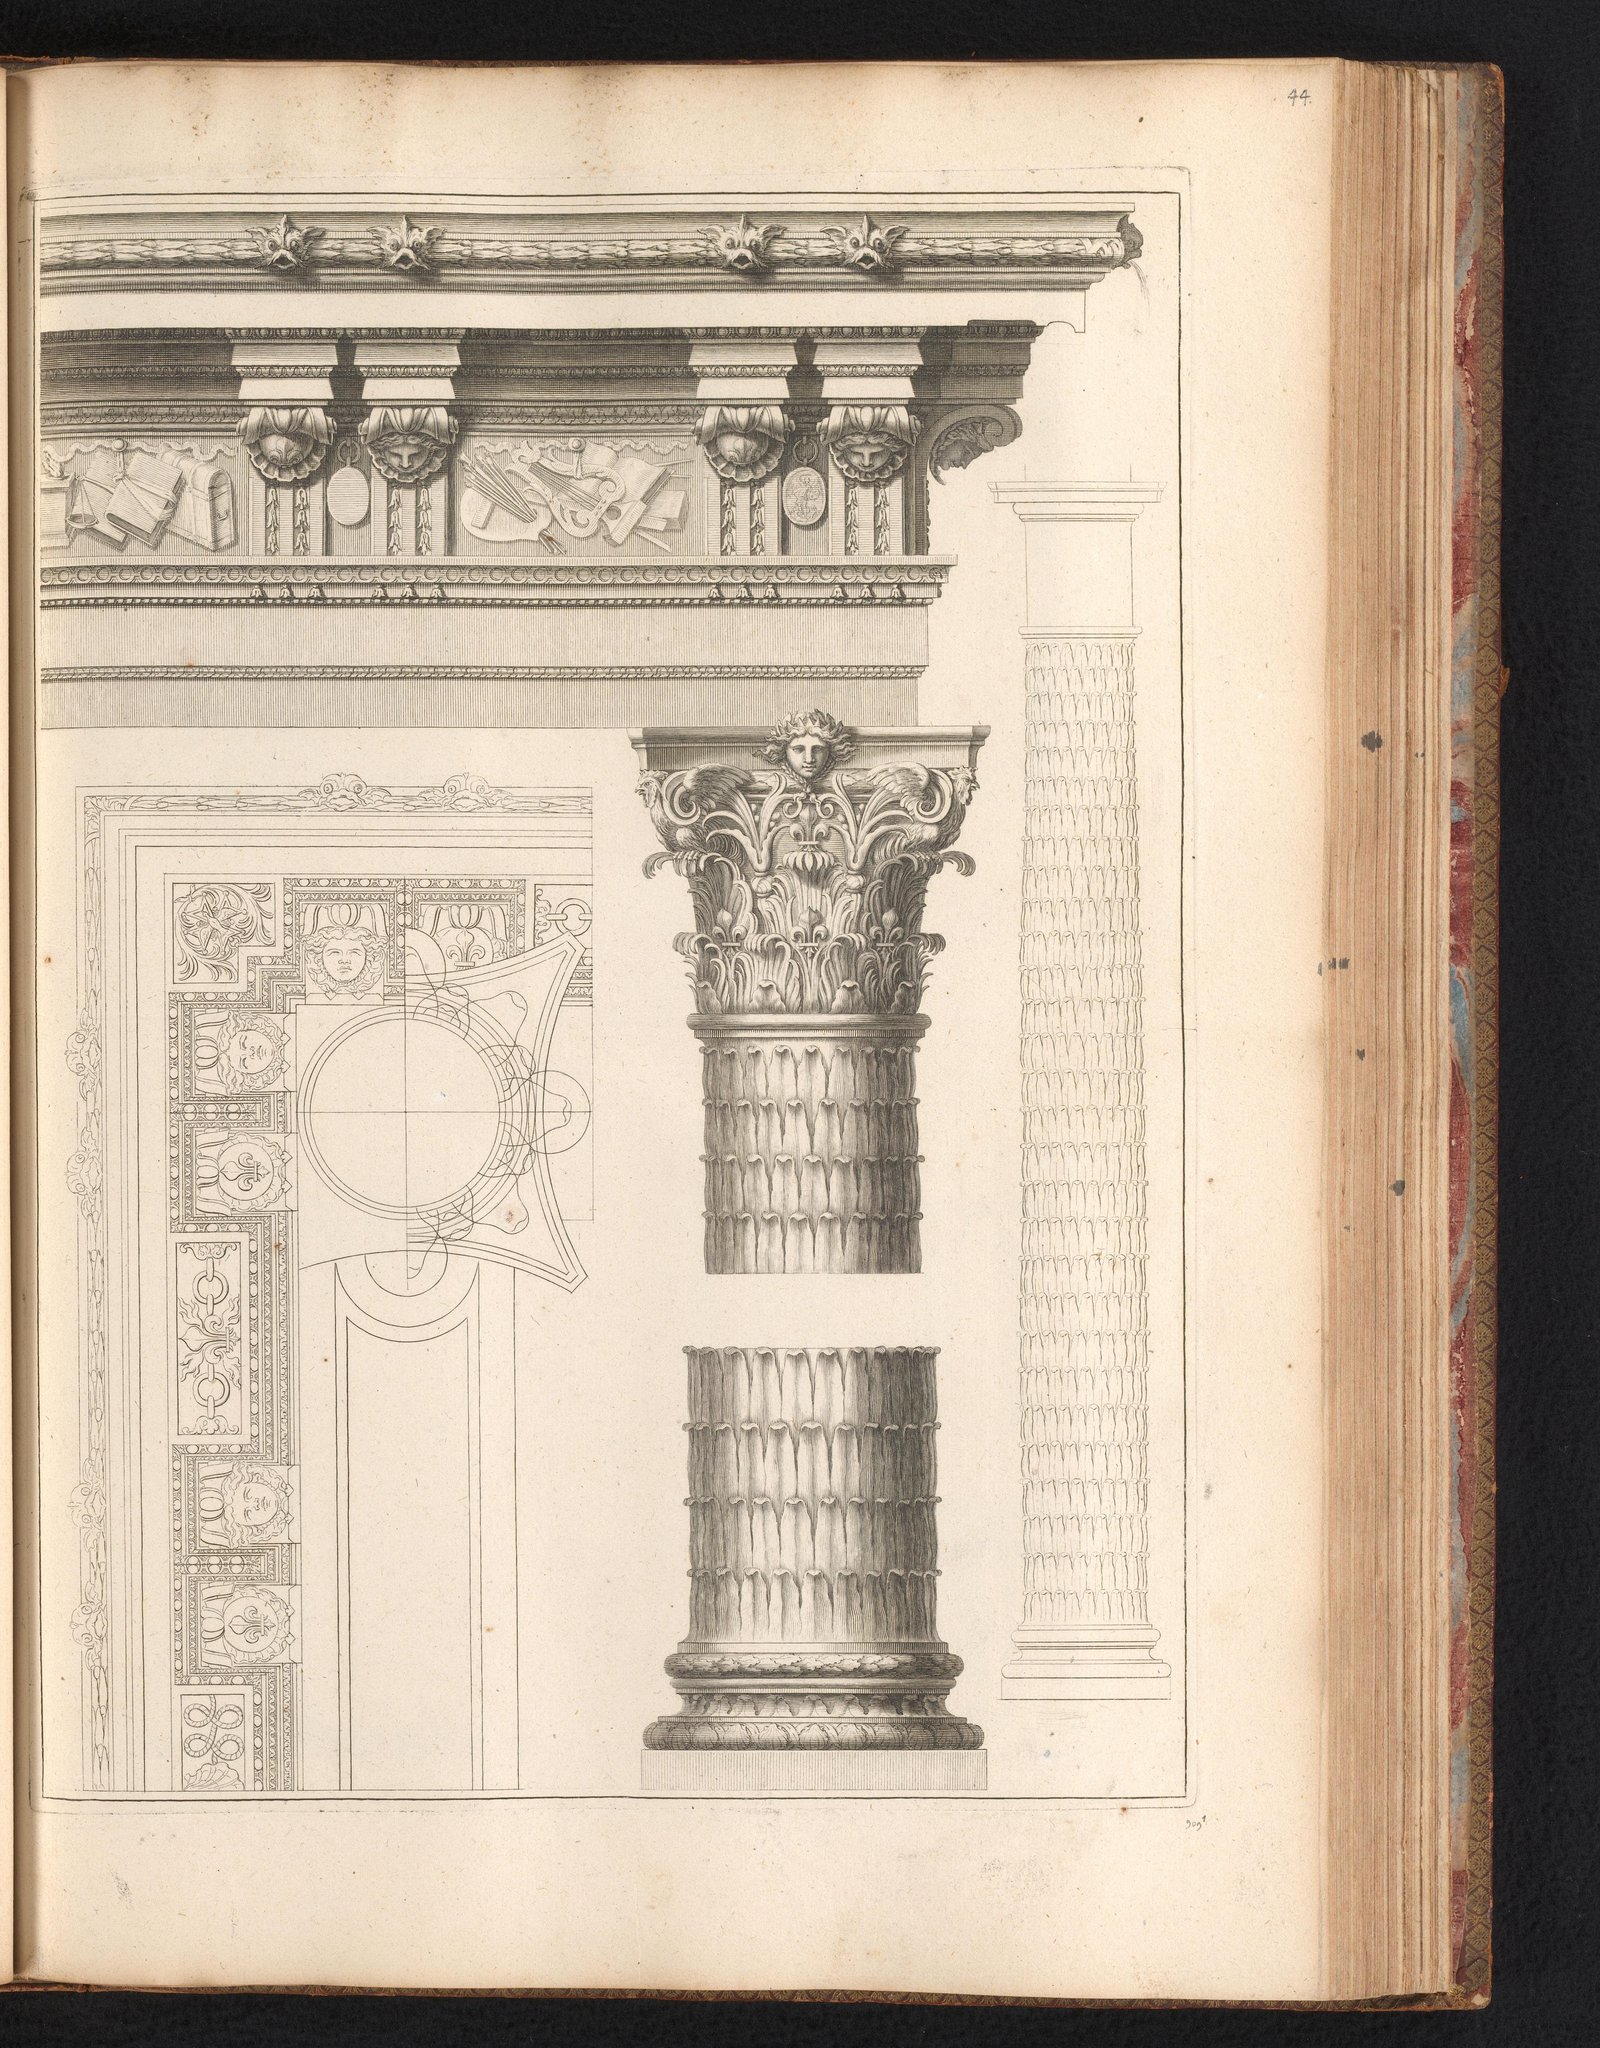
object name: print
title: Architectuur in de Franse Orde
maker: sébastien leclerc (i)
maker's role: print maker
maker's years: 1637-1714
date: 1685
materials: paper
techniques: engraving, etching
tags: orders, order-books ~ architecture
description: Onder meer een zuil in de door Charles le Brun ontworpen Franse Orde. Prent maakt deel uit van een album.